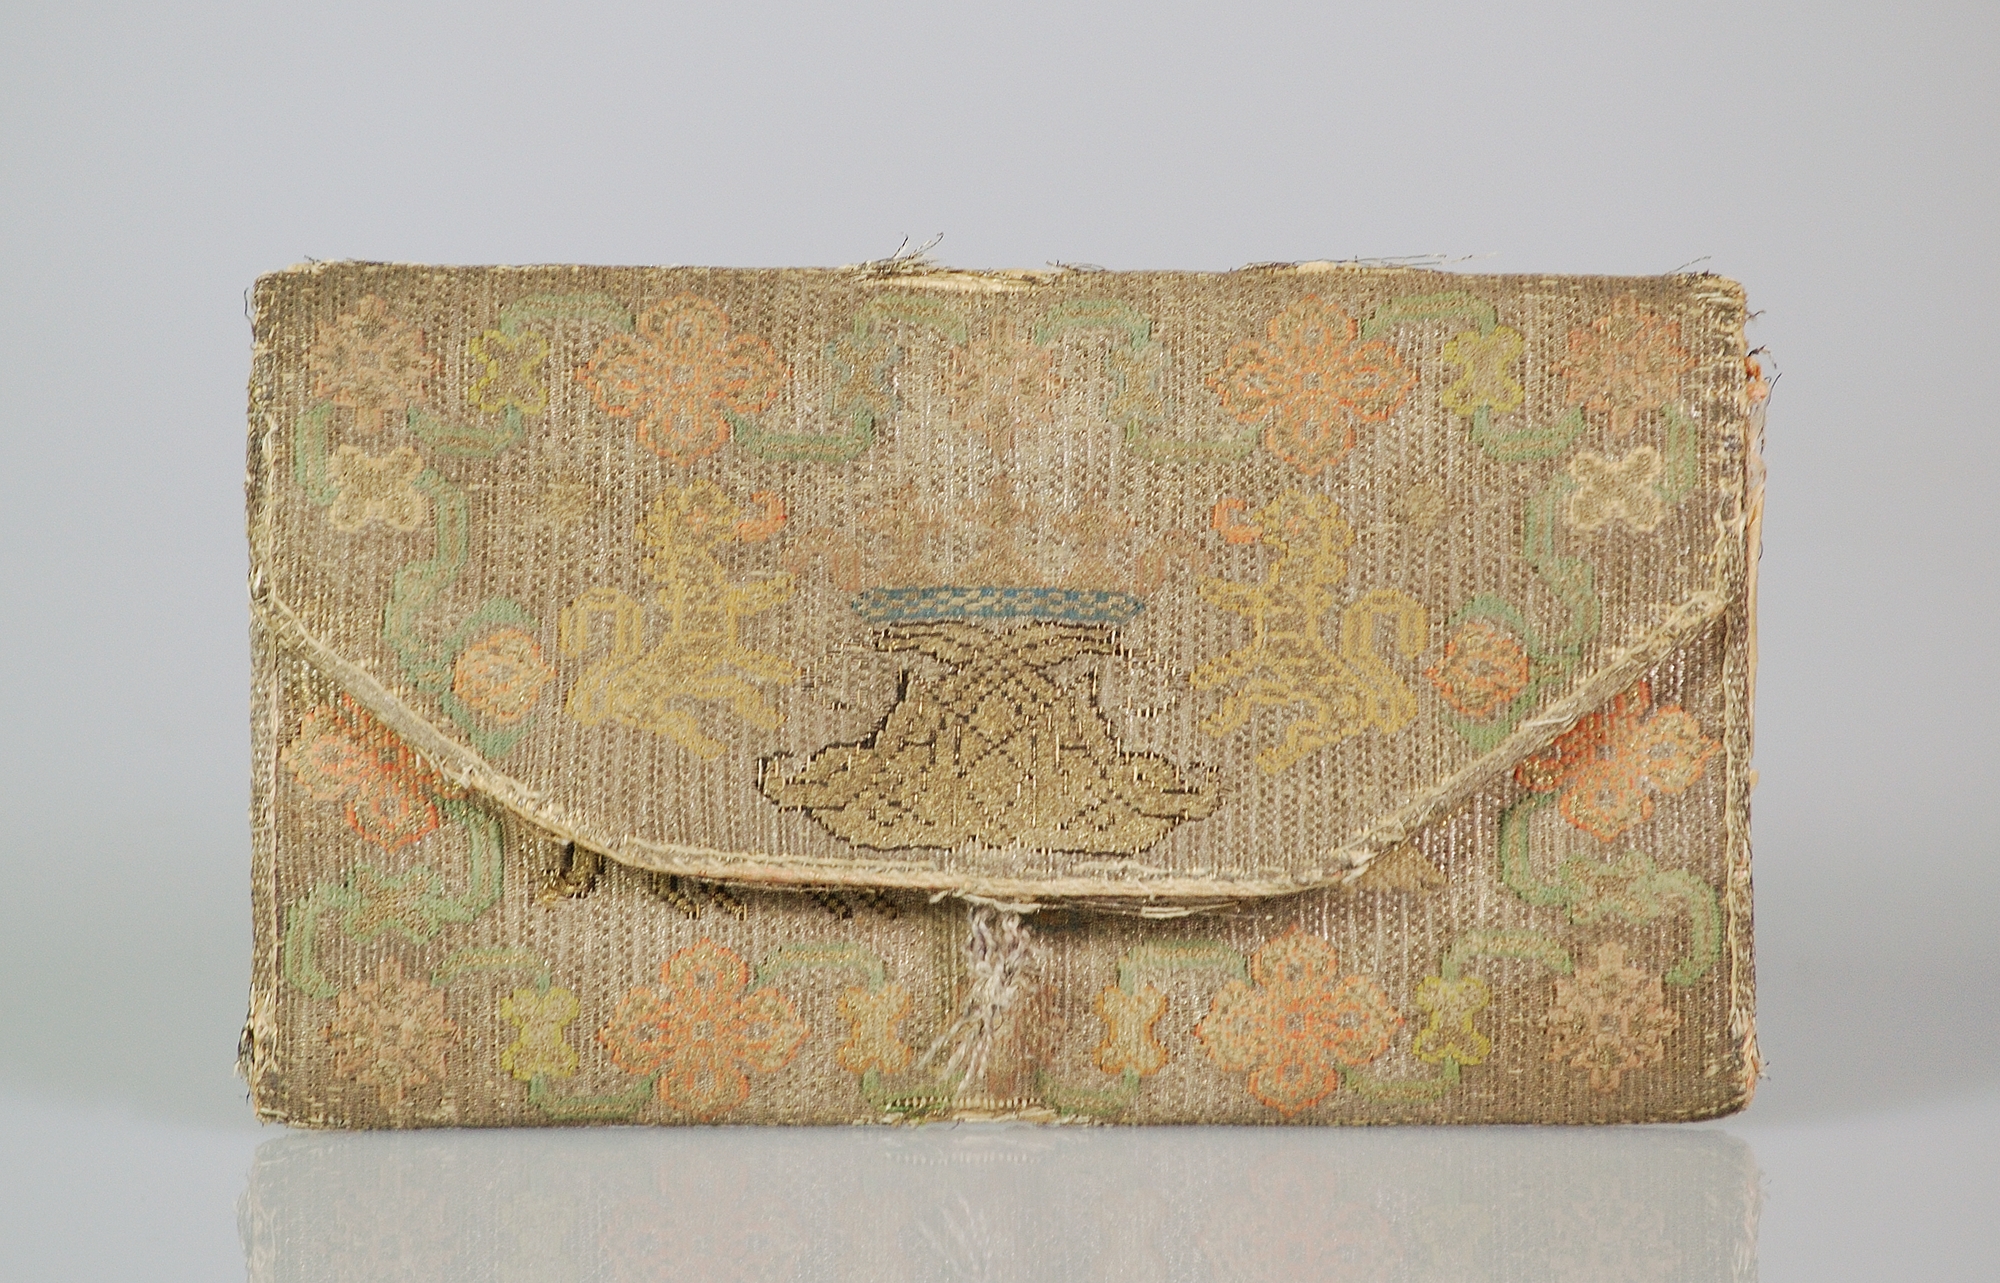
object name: bag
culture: european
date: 1725-1775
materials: metal, silk